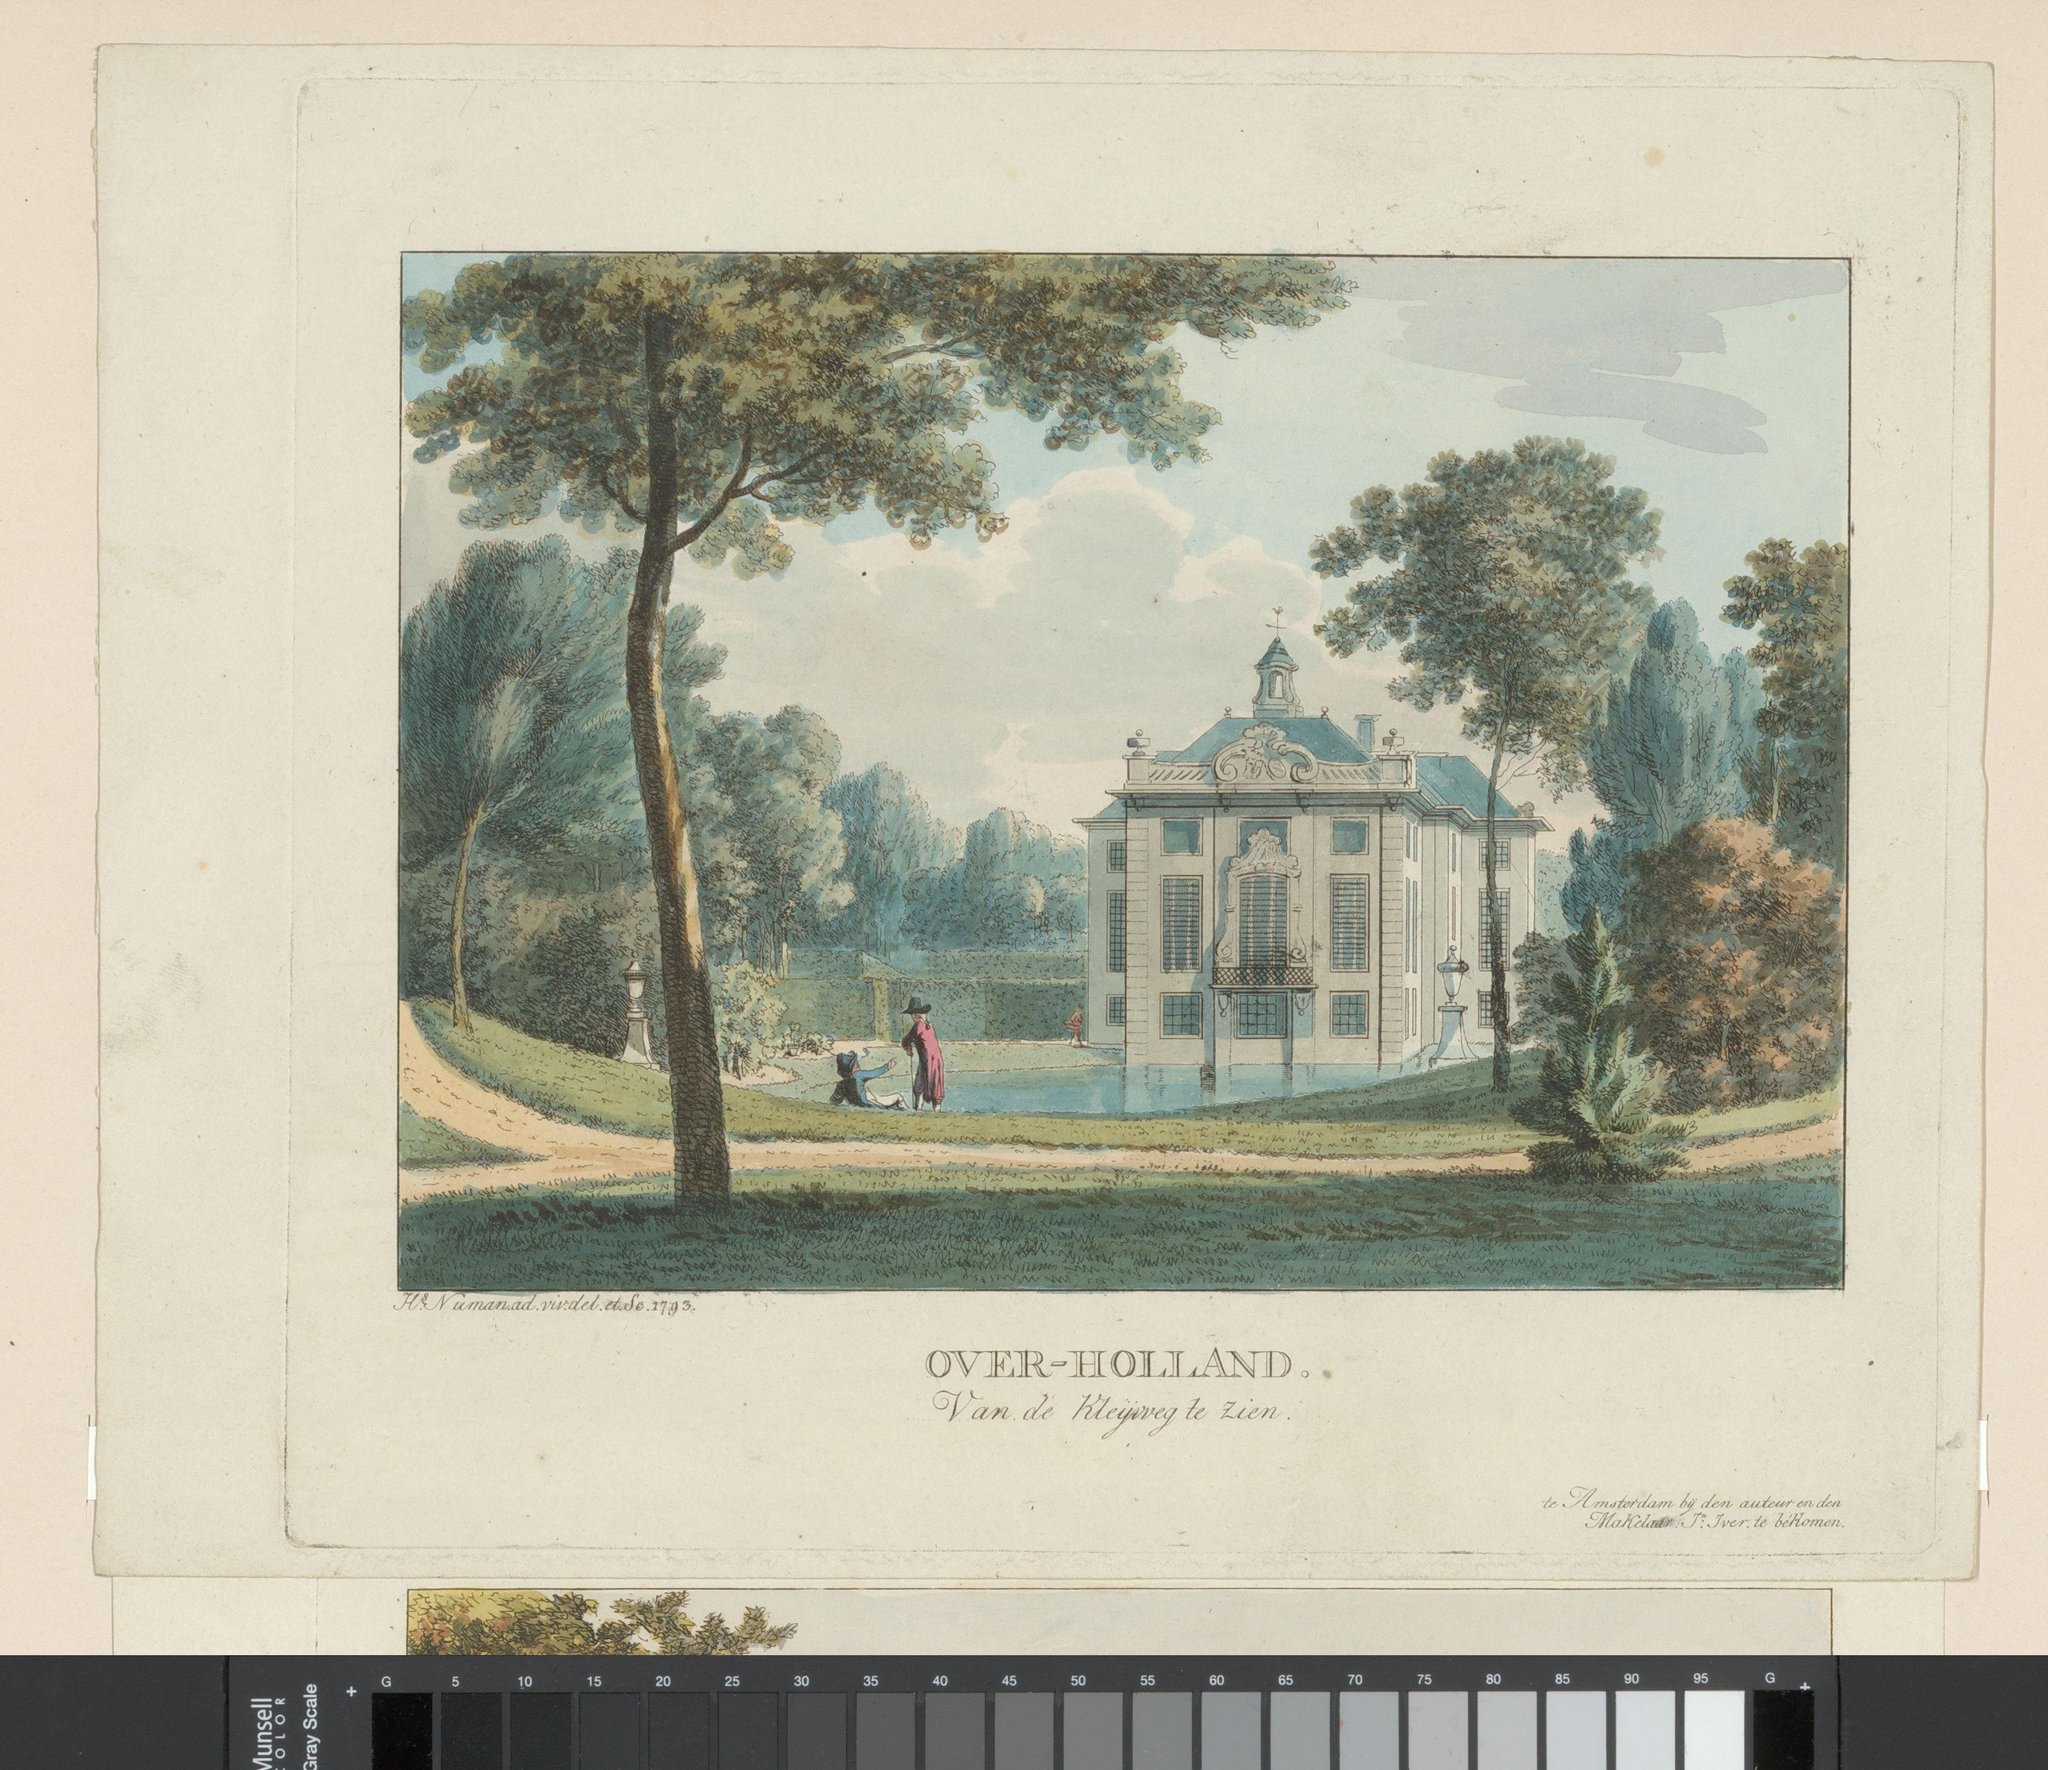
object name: print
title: Gezicht op Huis Over-Holland aan de Vecht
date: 1793-1797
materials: paper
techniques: engraving, etching, hand coloring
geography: amsterdam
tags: country-house, vecht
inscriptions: stamp, collector's mark: Lugt 1641, stamp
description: Prent mogelijk uit: Numan, Hermanus. Vierentwintig printtekeningen met couleuren, verbeeldende Hollandsche buitenplaatzen. Amsterdam: Jan IJver, Jan Willem Smit en Hermanus Numan, 1797.